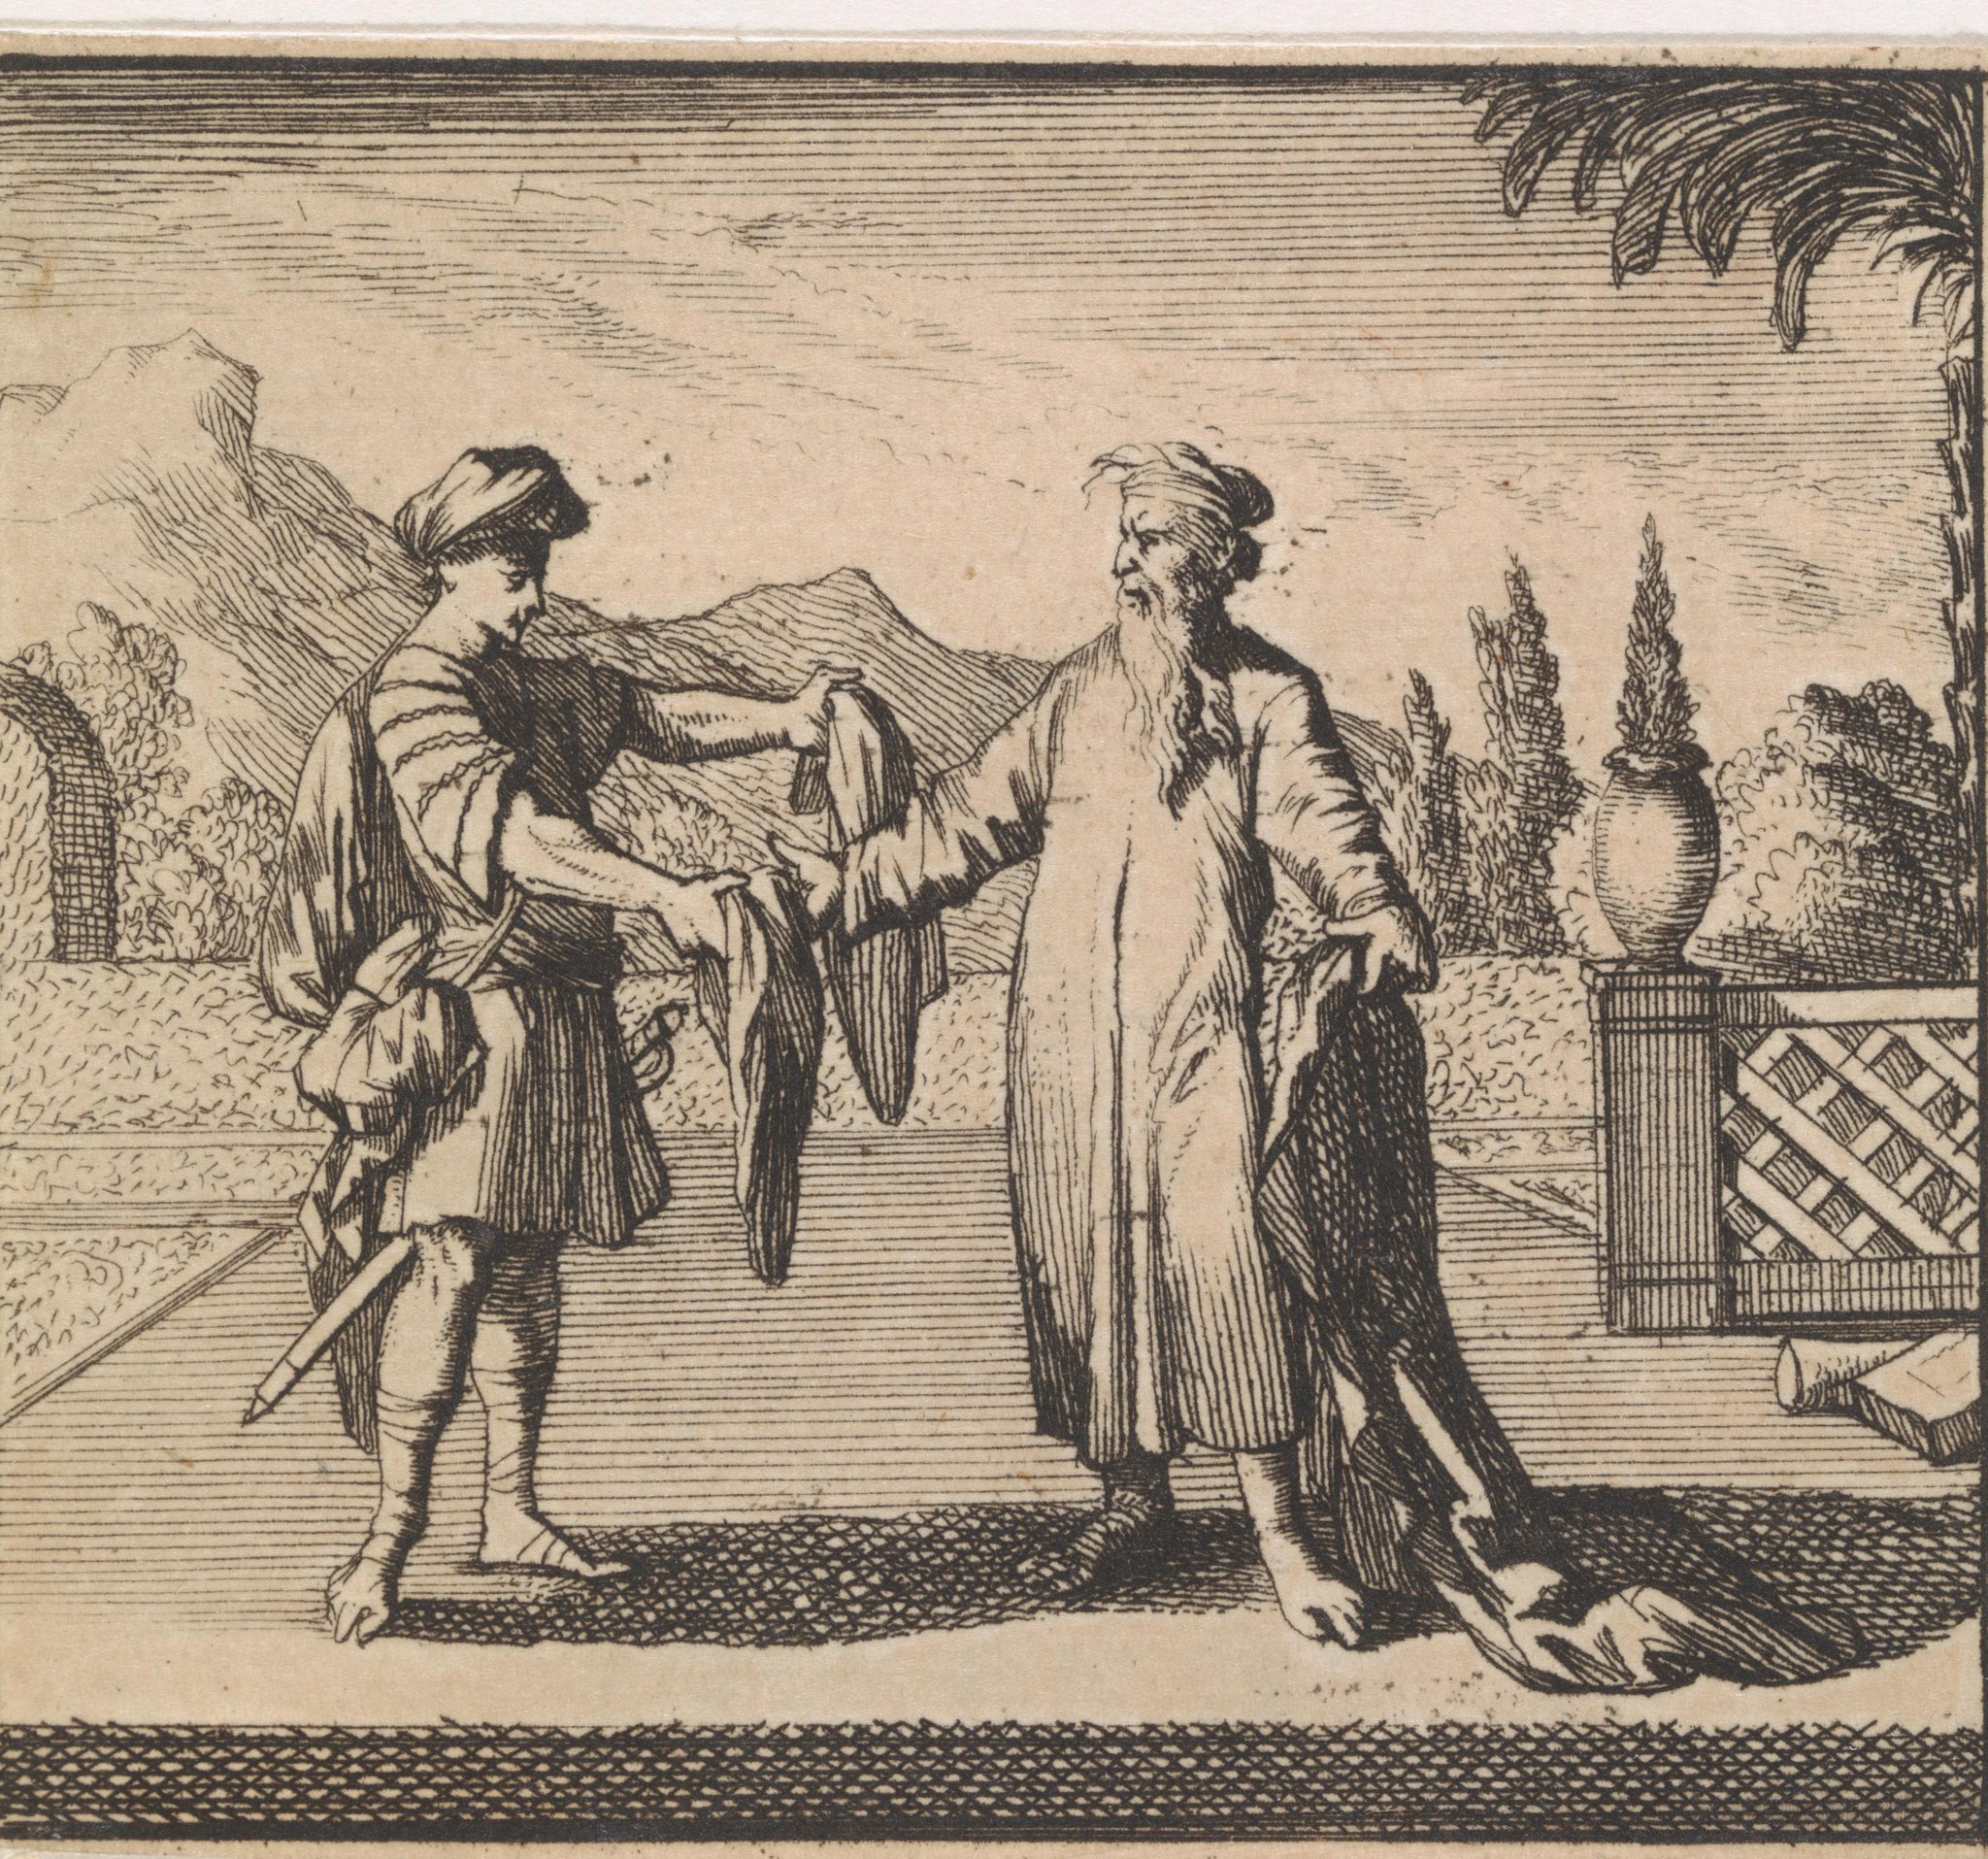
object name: print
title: Ahias verscheurt de nieuwe mantel van Jerobeam in twaalf stukken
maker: caspar luyken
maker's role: draughtsman, print maker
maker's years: 1672-1708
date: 1698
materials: paper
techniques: etching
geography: amsterdam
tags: meeting of jeroboam and the prophet ahijah; ahijah rends his garment in twelve pieces, ten of which he gives to jeroboam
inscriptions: collector's mark: Lugt 2228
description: Proefdruk van illustratie uit: Josephus, Flavius. XX. boeken van de oude geschiedenissen der joden, 4 delen. Amsterdam: Barent Visscher, Willem de Coup, Willem van Lamsveld, Andries van Damme, 1698, dl. I.